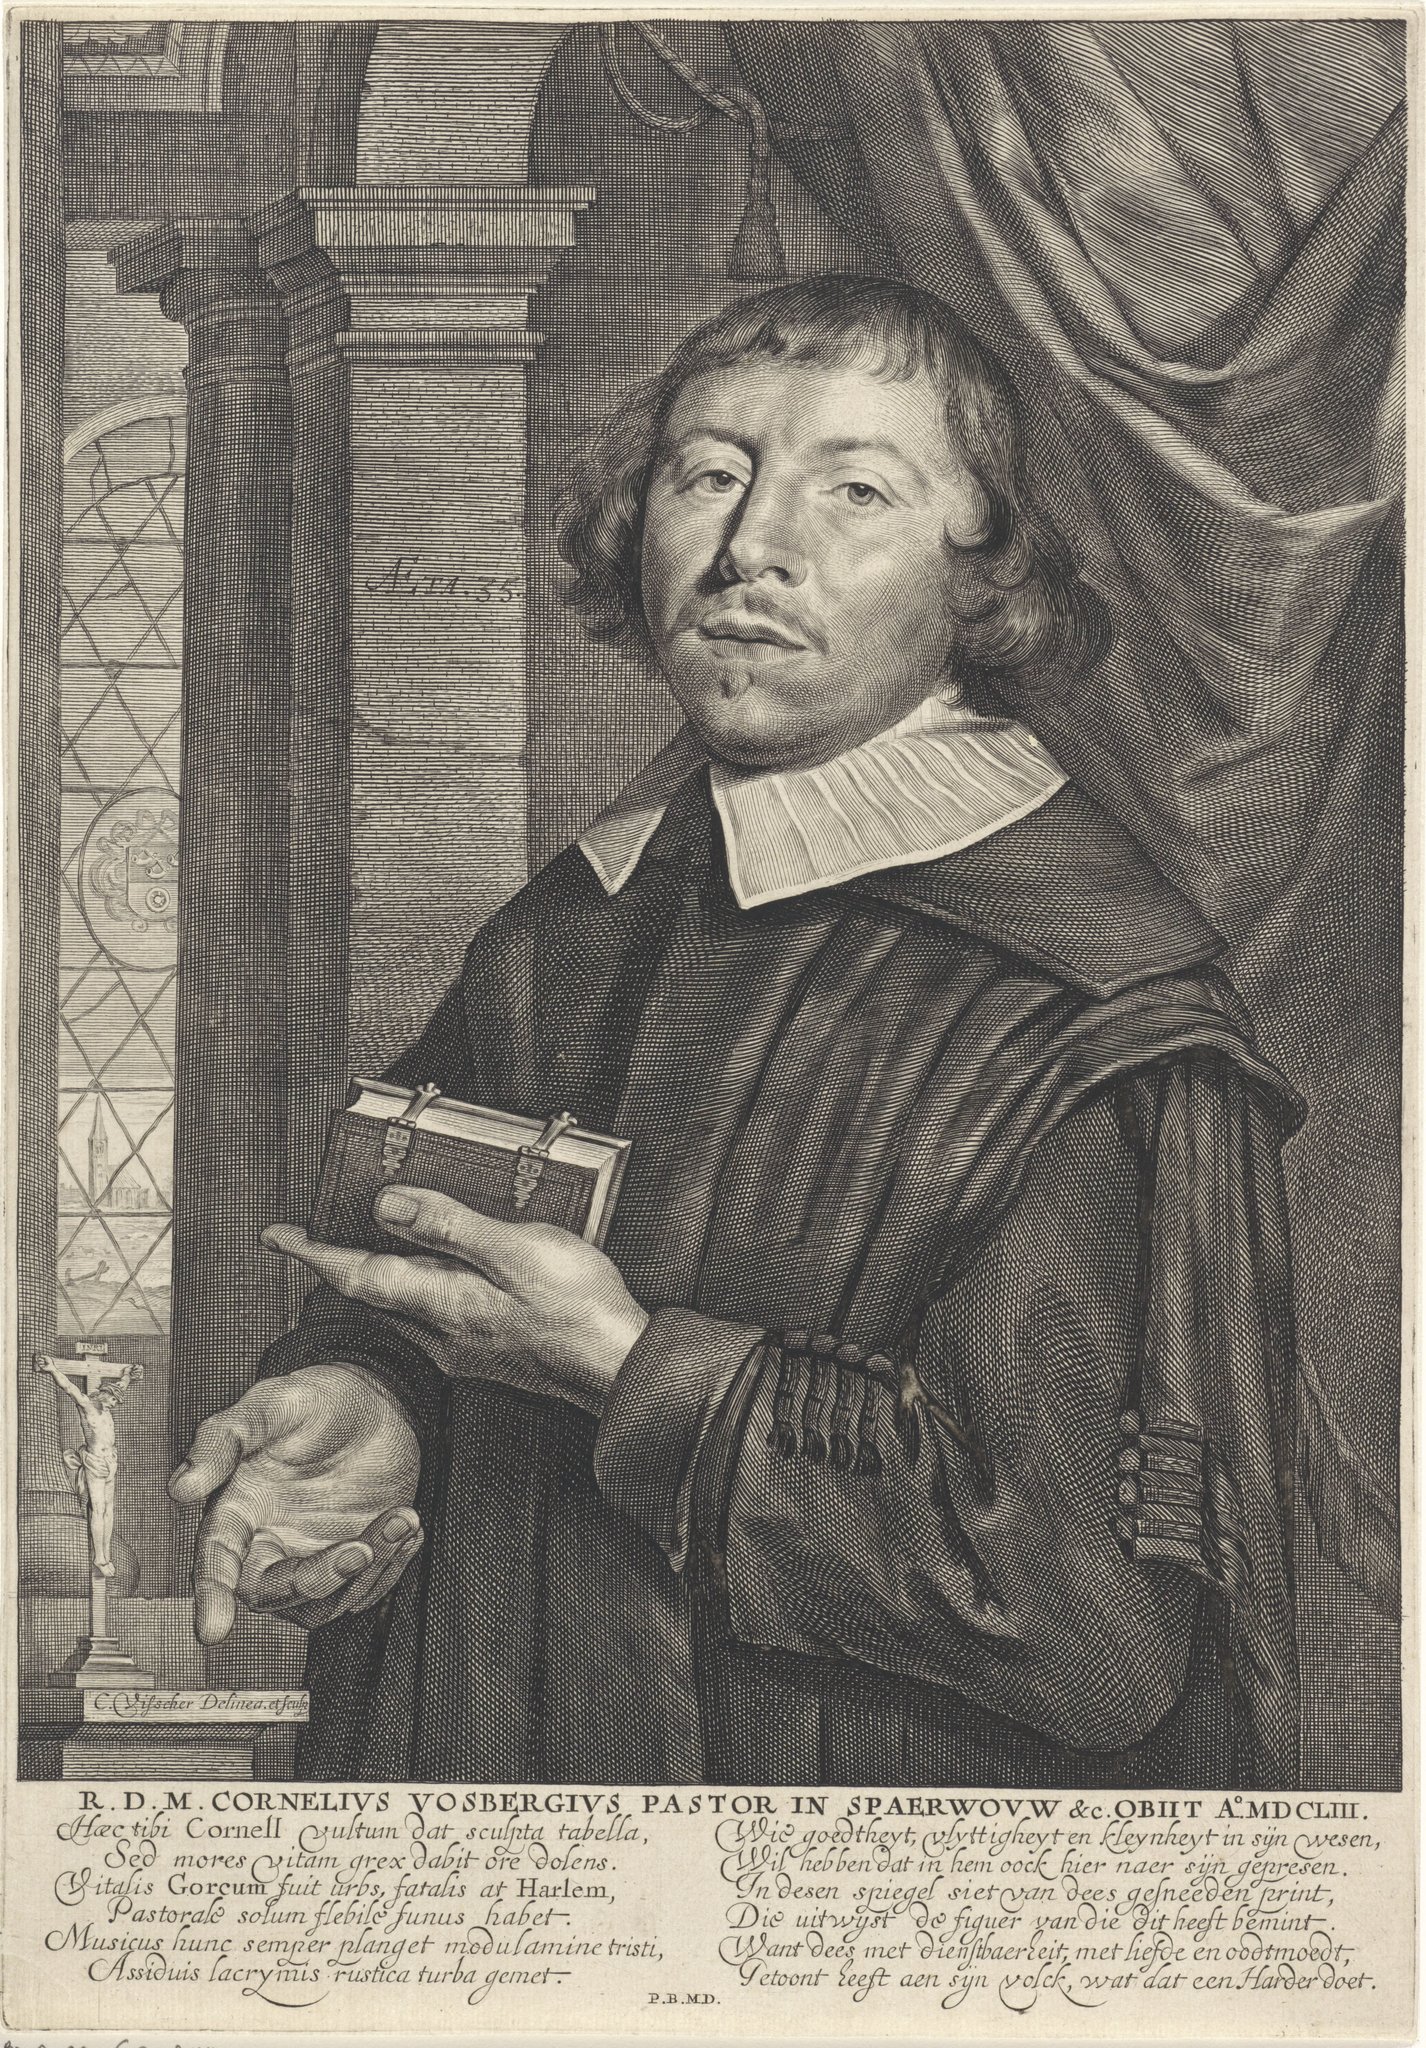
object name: print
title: Portret van Cornelius Vosbergen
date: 1653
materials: paper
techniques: engraving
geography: haarlem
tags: priest, bible, church (exterior), crucifix ~ personal devotion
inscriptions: collector's mark: Lugt 240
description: Cornelius Vosbergen op 35-jarige leeftijd. Hij was pastoor in Spaarnwoude. In zijn hand een bijbel en voor hem een crucifix. Door het raam is een landschap met een kerk te zien.